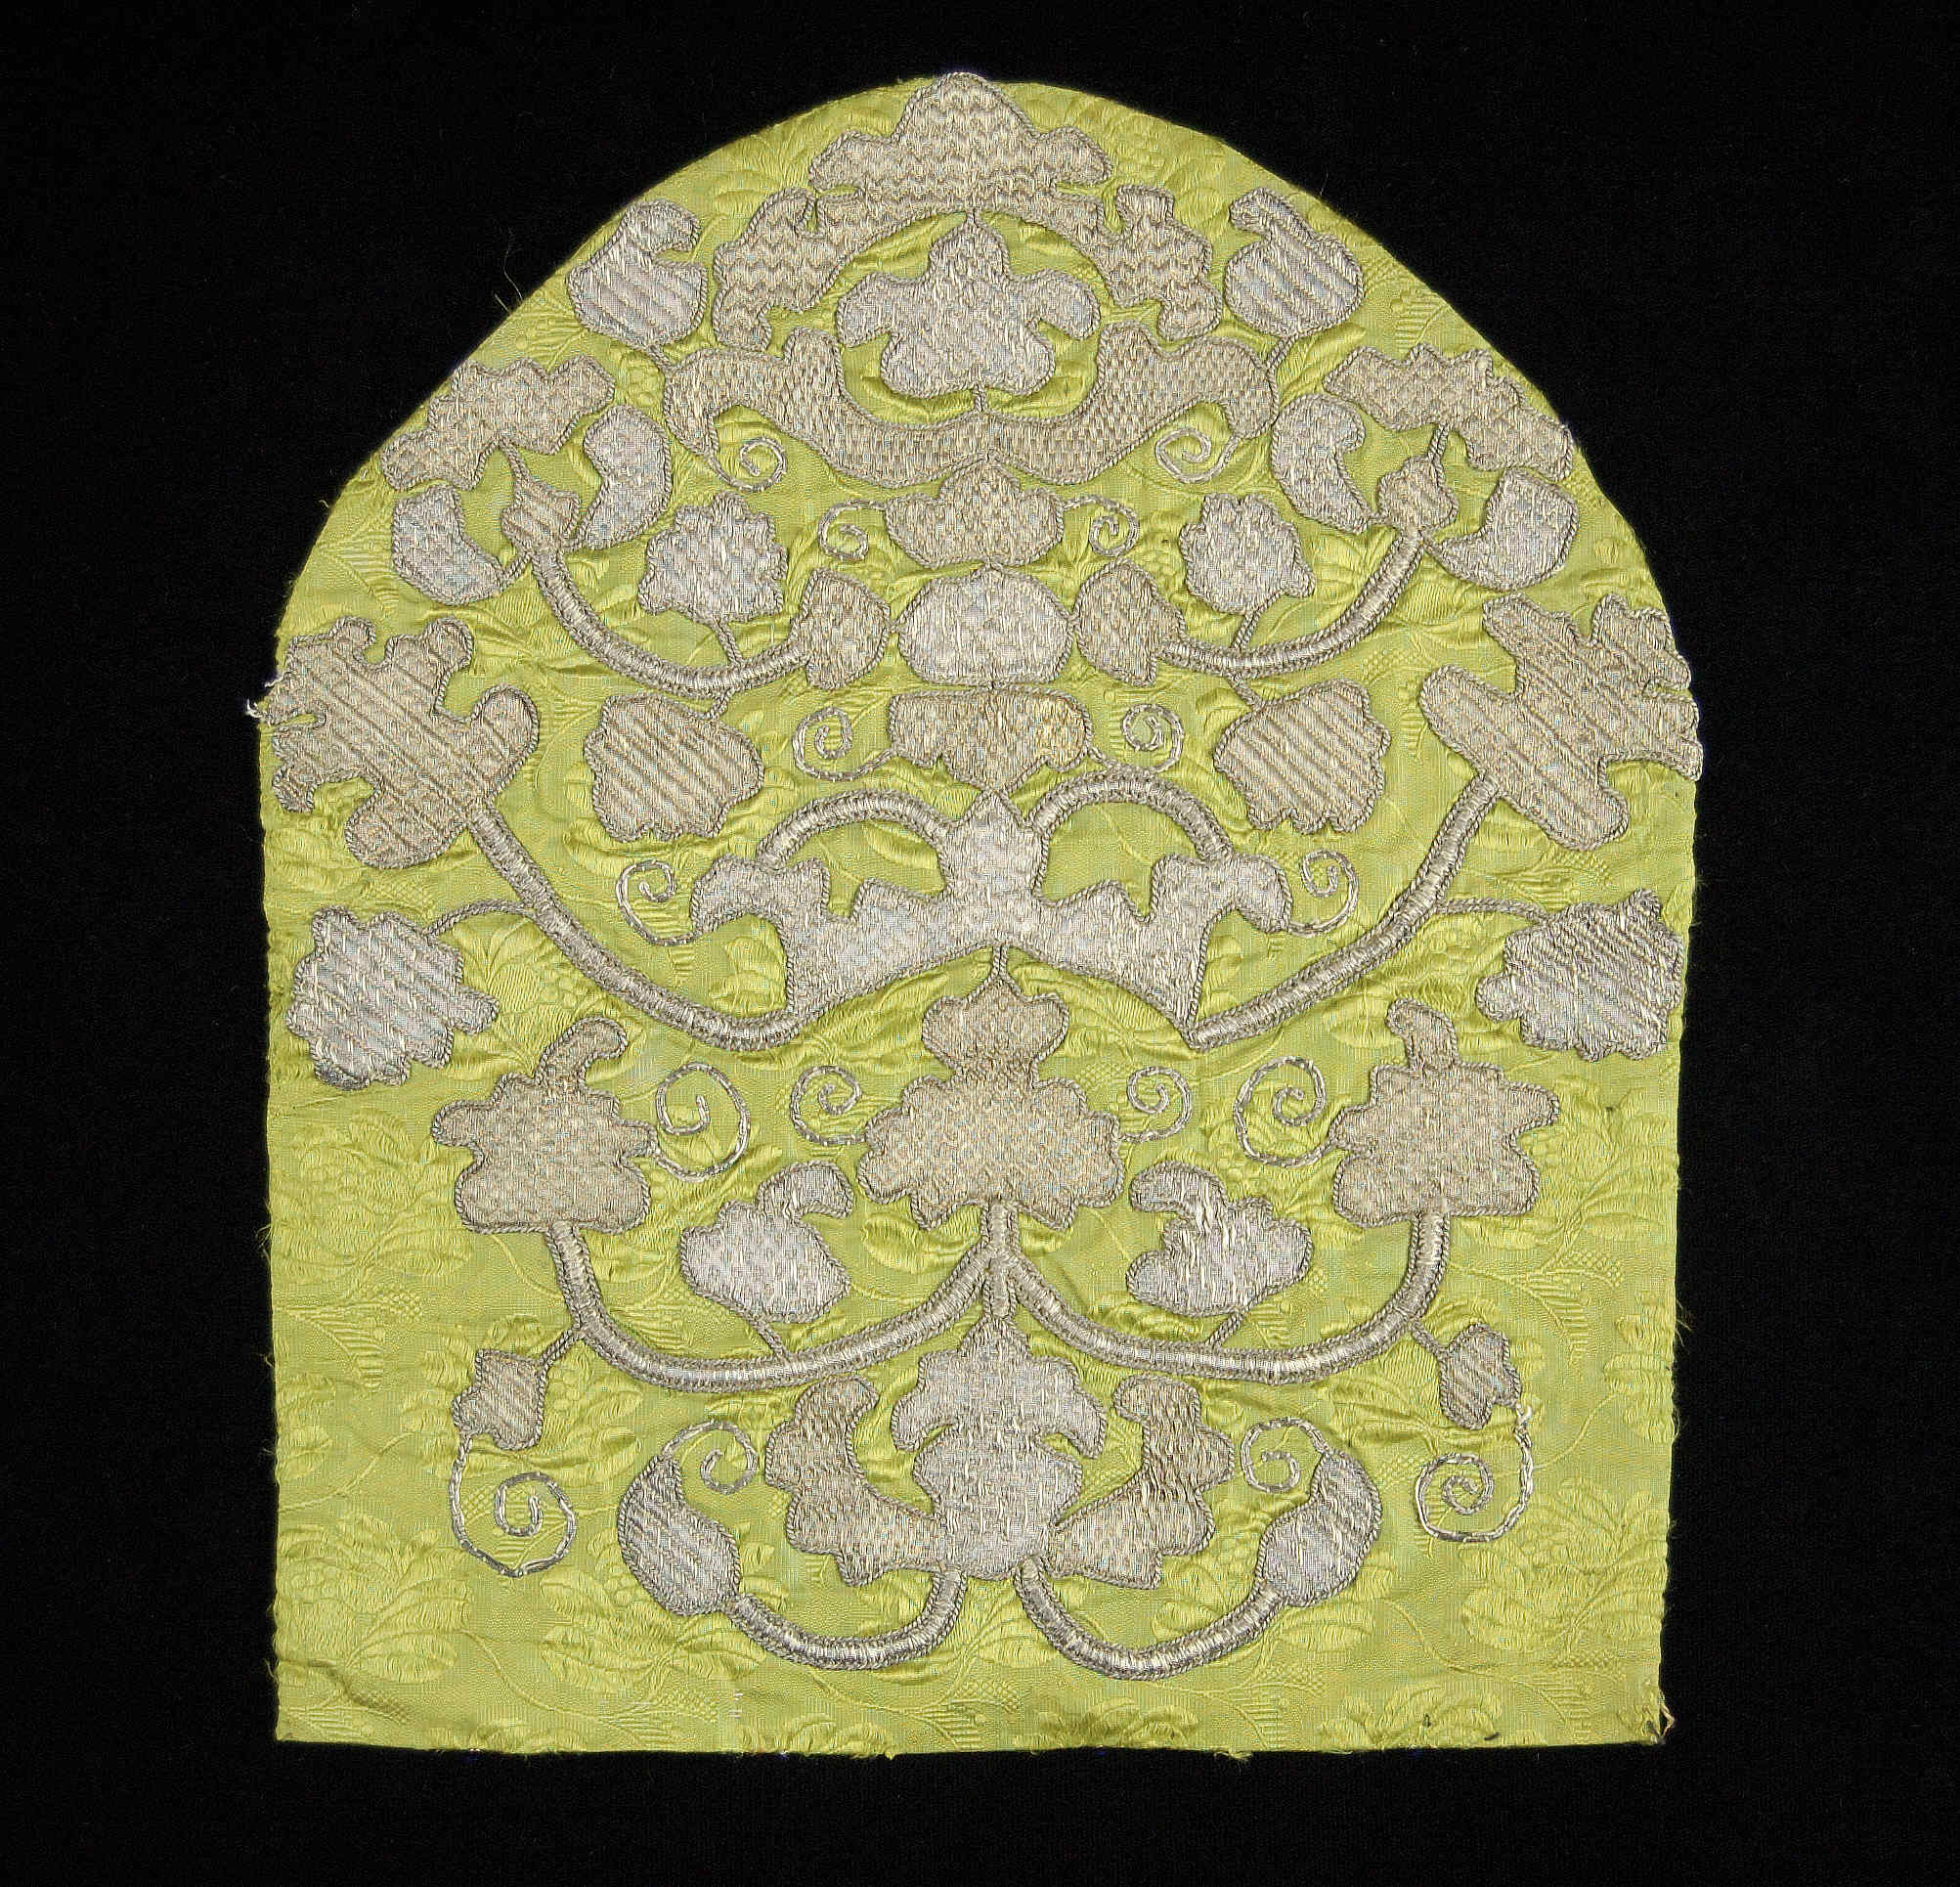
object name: headdress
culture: russian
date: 1801-1900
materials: linen, silk